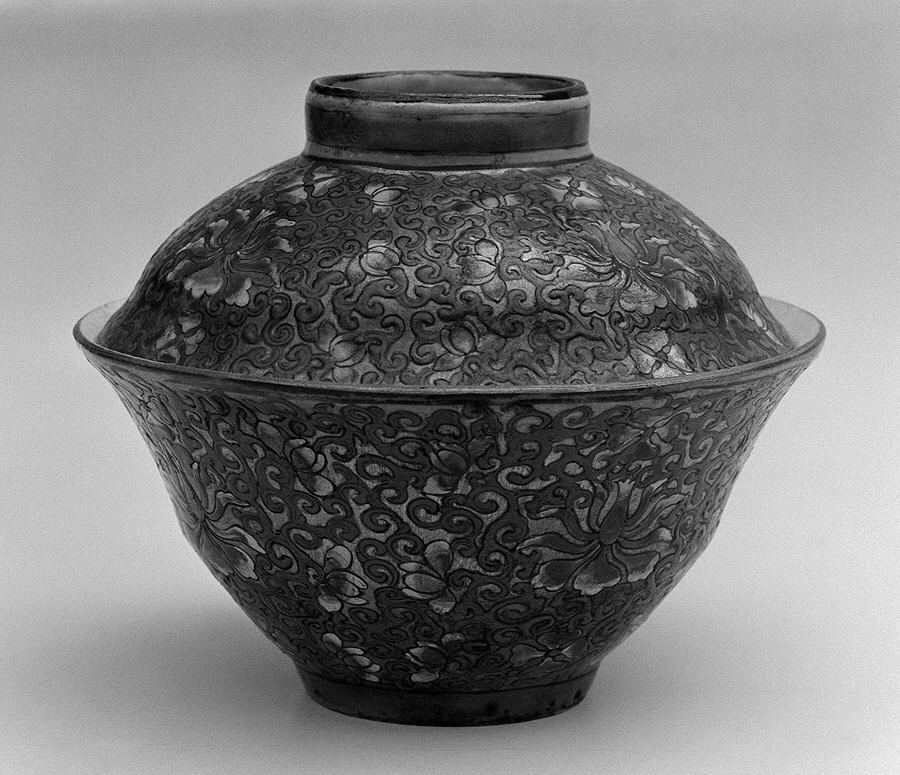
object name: bowl with cover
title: Covered bowl with floral patterns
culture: chinese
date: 1834-1866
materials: enamel, porcelain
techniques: overglaze, painting, polychrome